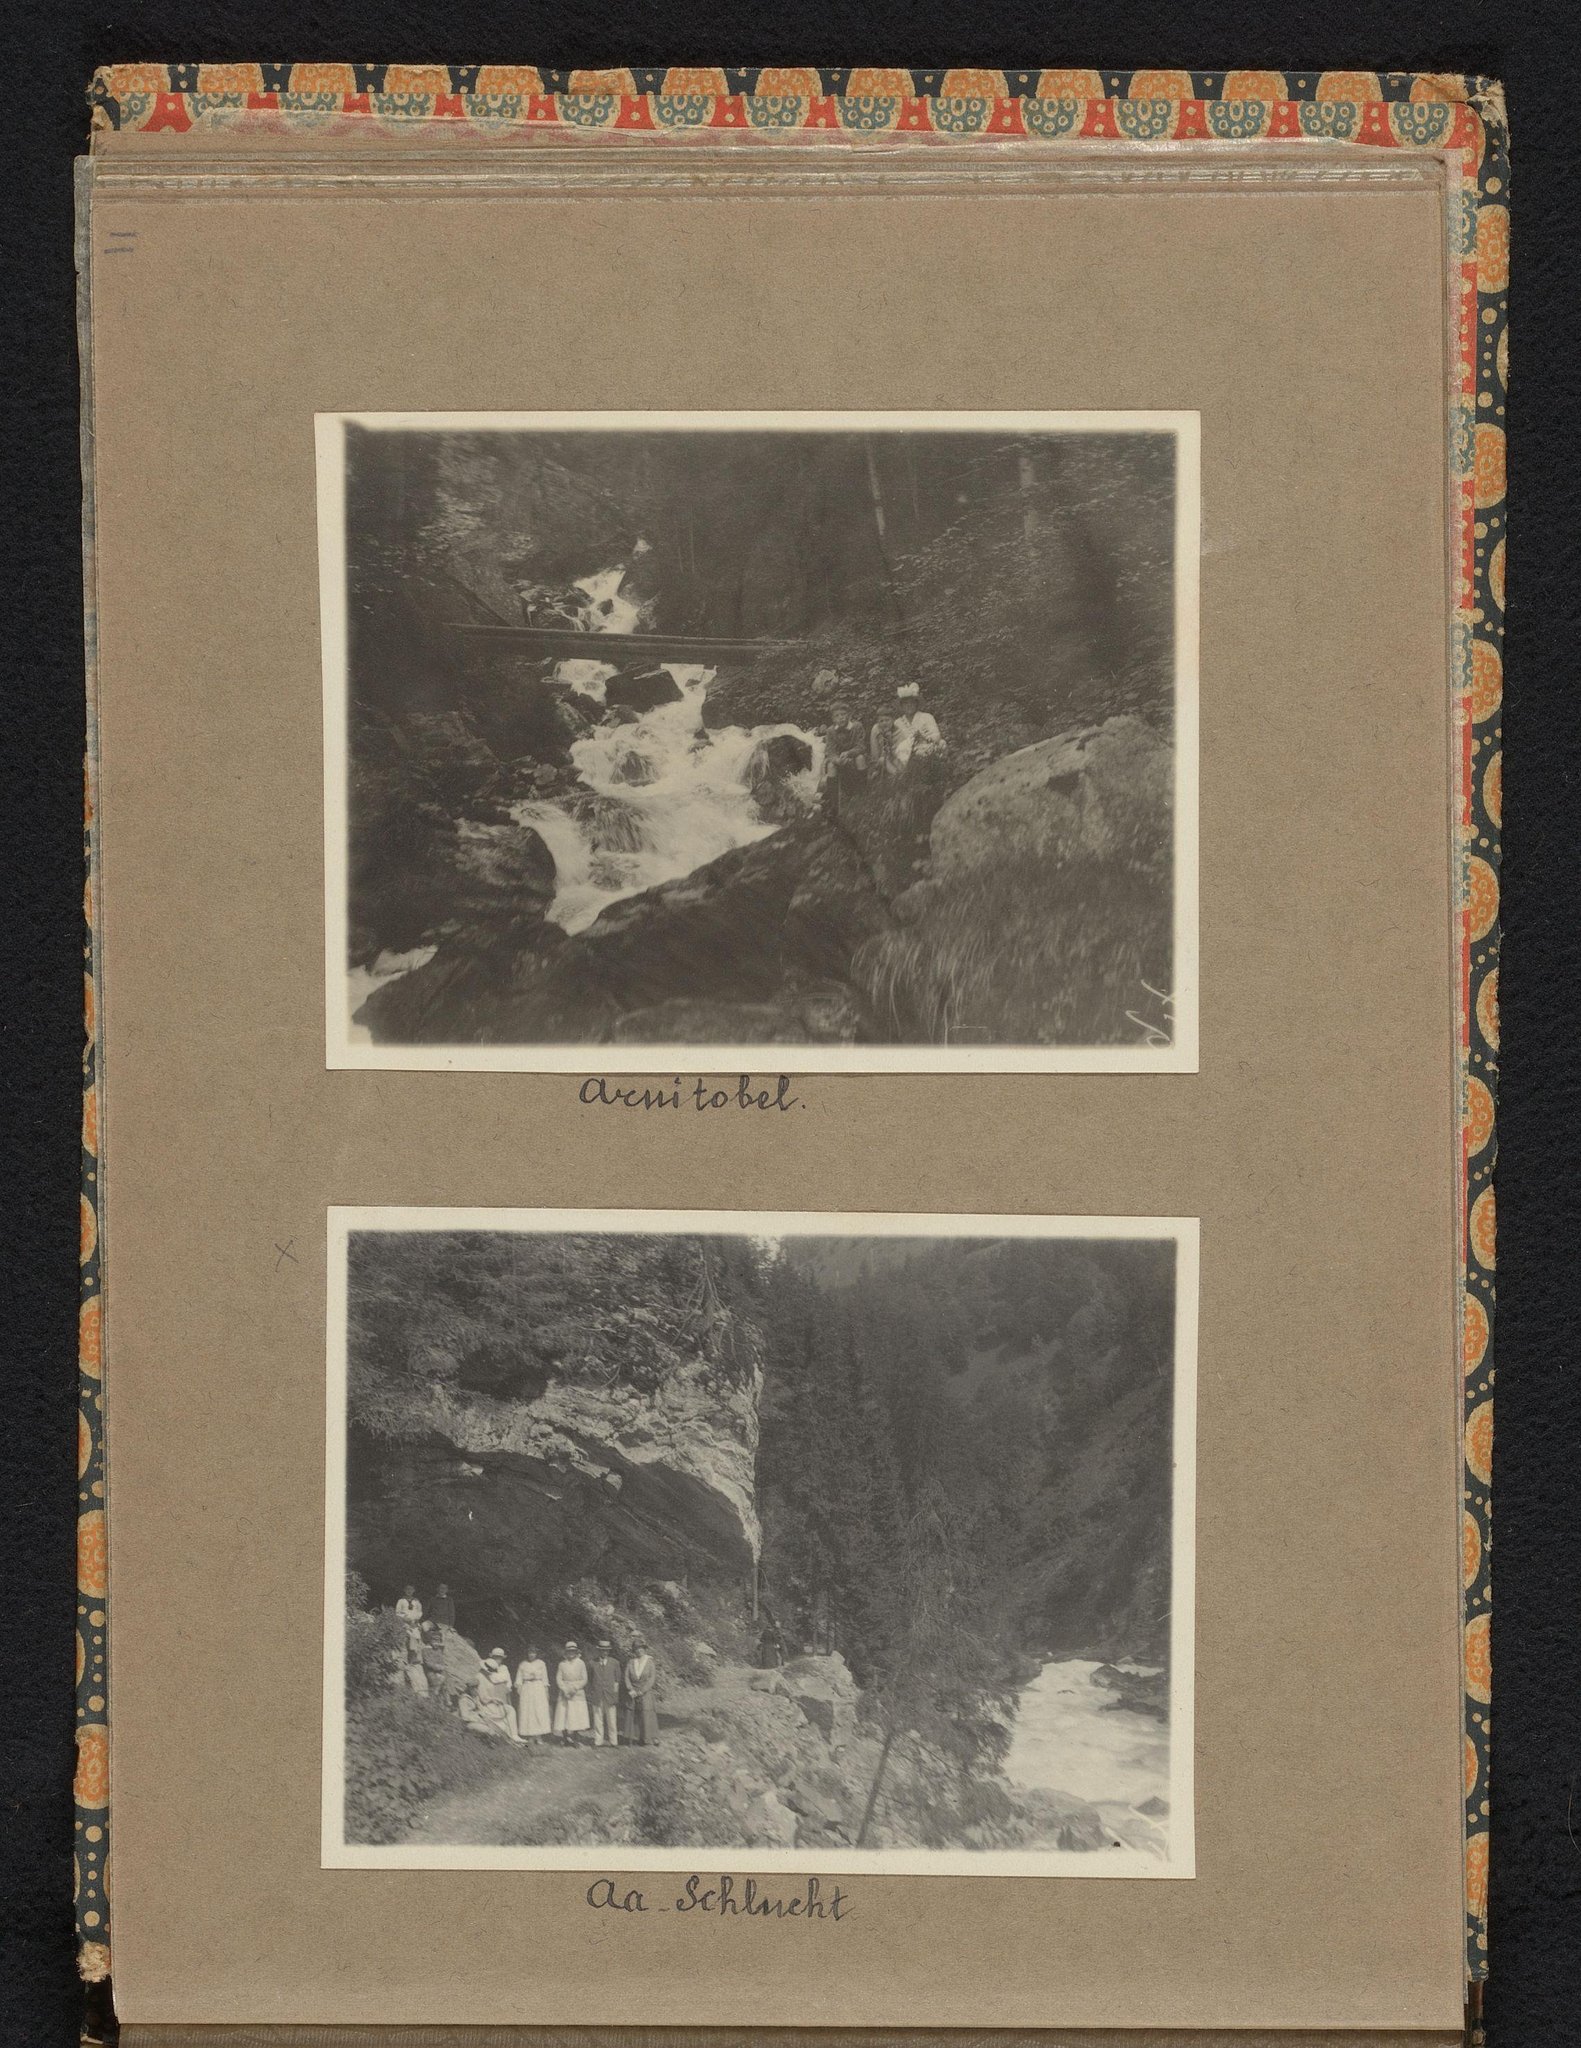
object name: photograph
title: Twee foto's van familie Van den Berg tijdens een wandeling bij de Arnibach en de Aaschlucht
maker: hendrik herman van den berg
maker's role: amateurfotograaf, jurist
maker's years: 1875-1944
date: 1920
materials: paper, cardboard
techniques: gelatin silver print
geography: engelberg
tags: the hague, caroline louise van den berg-van den berg, carel frederik van den berg (cay), frank willem van den berg (1912-1998), the family travelling, on holiday, walking, hiking (recreation), historical persons, mountains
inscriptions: caption: ‘Arnitobel./ Aa-Schlucht’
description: Deze foto's maken deel uit van een album.